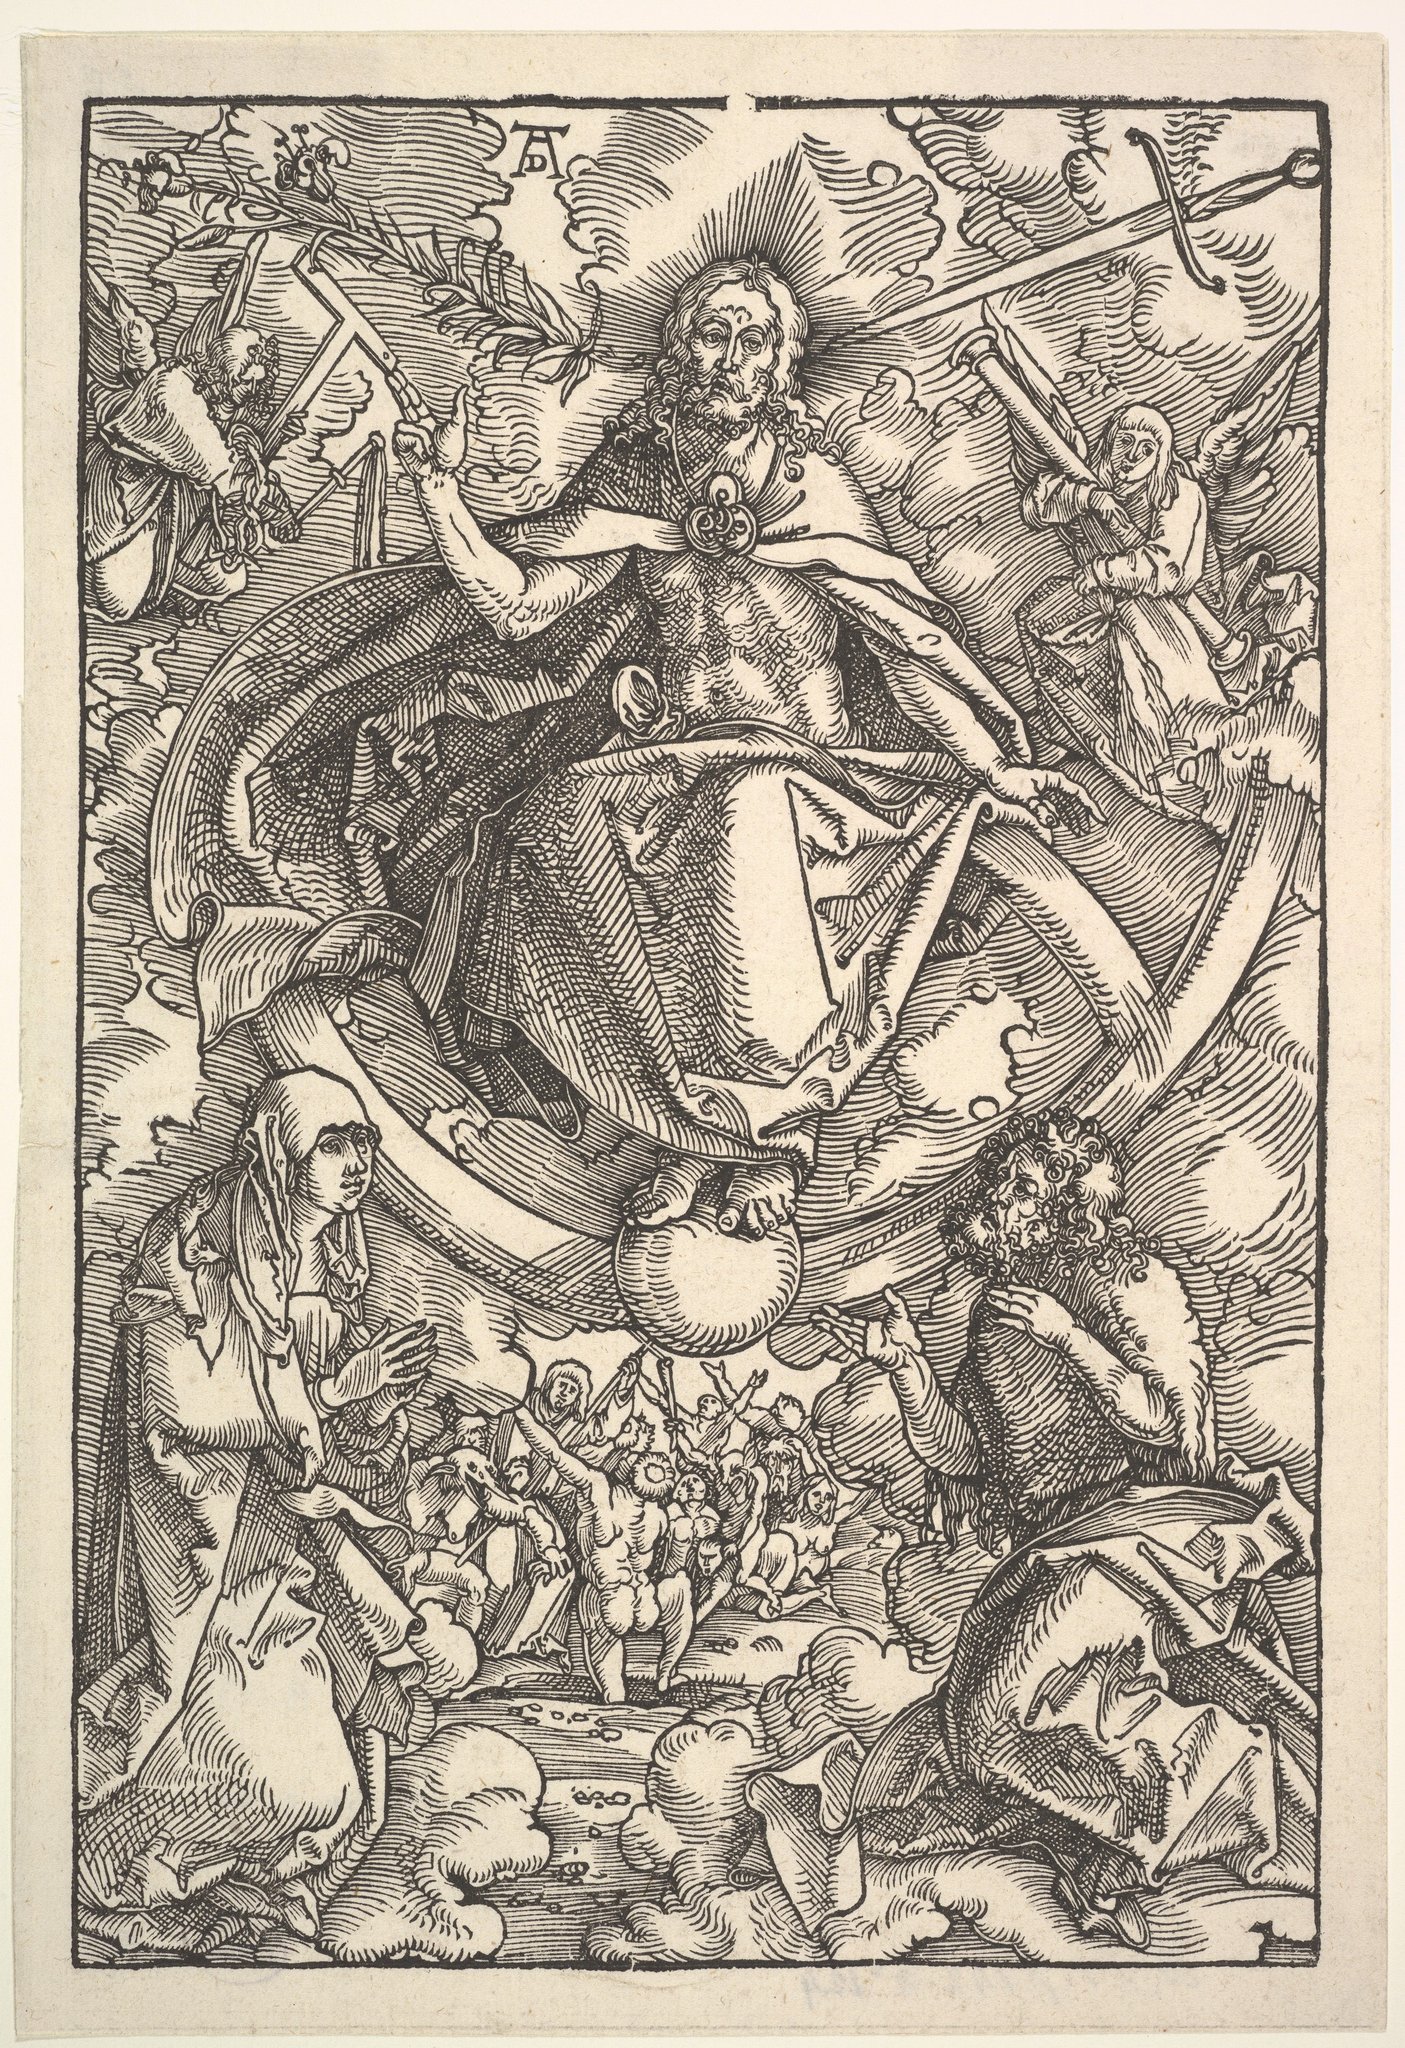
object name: print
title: The Last Judgment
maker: hans baldung (called hans baldung grien)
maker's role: artist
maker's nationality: german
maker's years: 1484-1545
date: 1505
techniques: woodcut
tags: swords,men,women,christ,last judgement